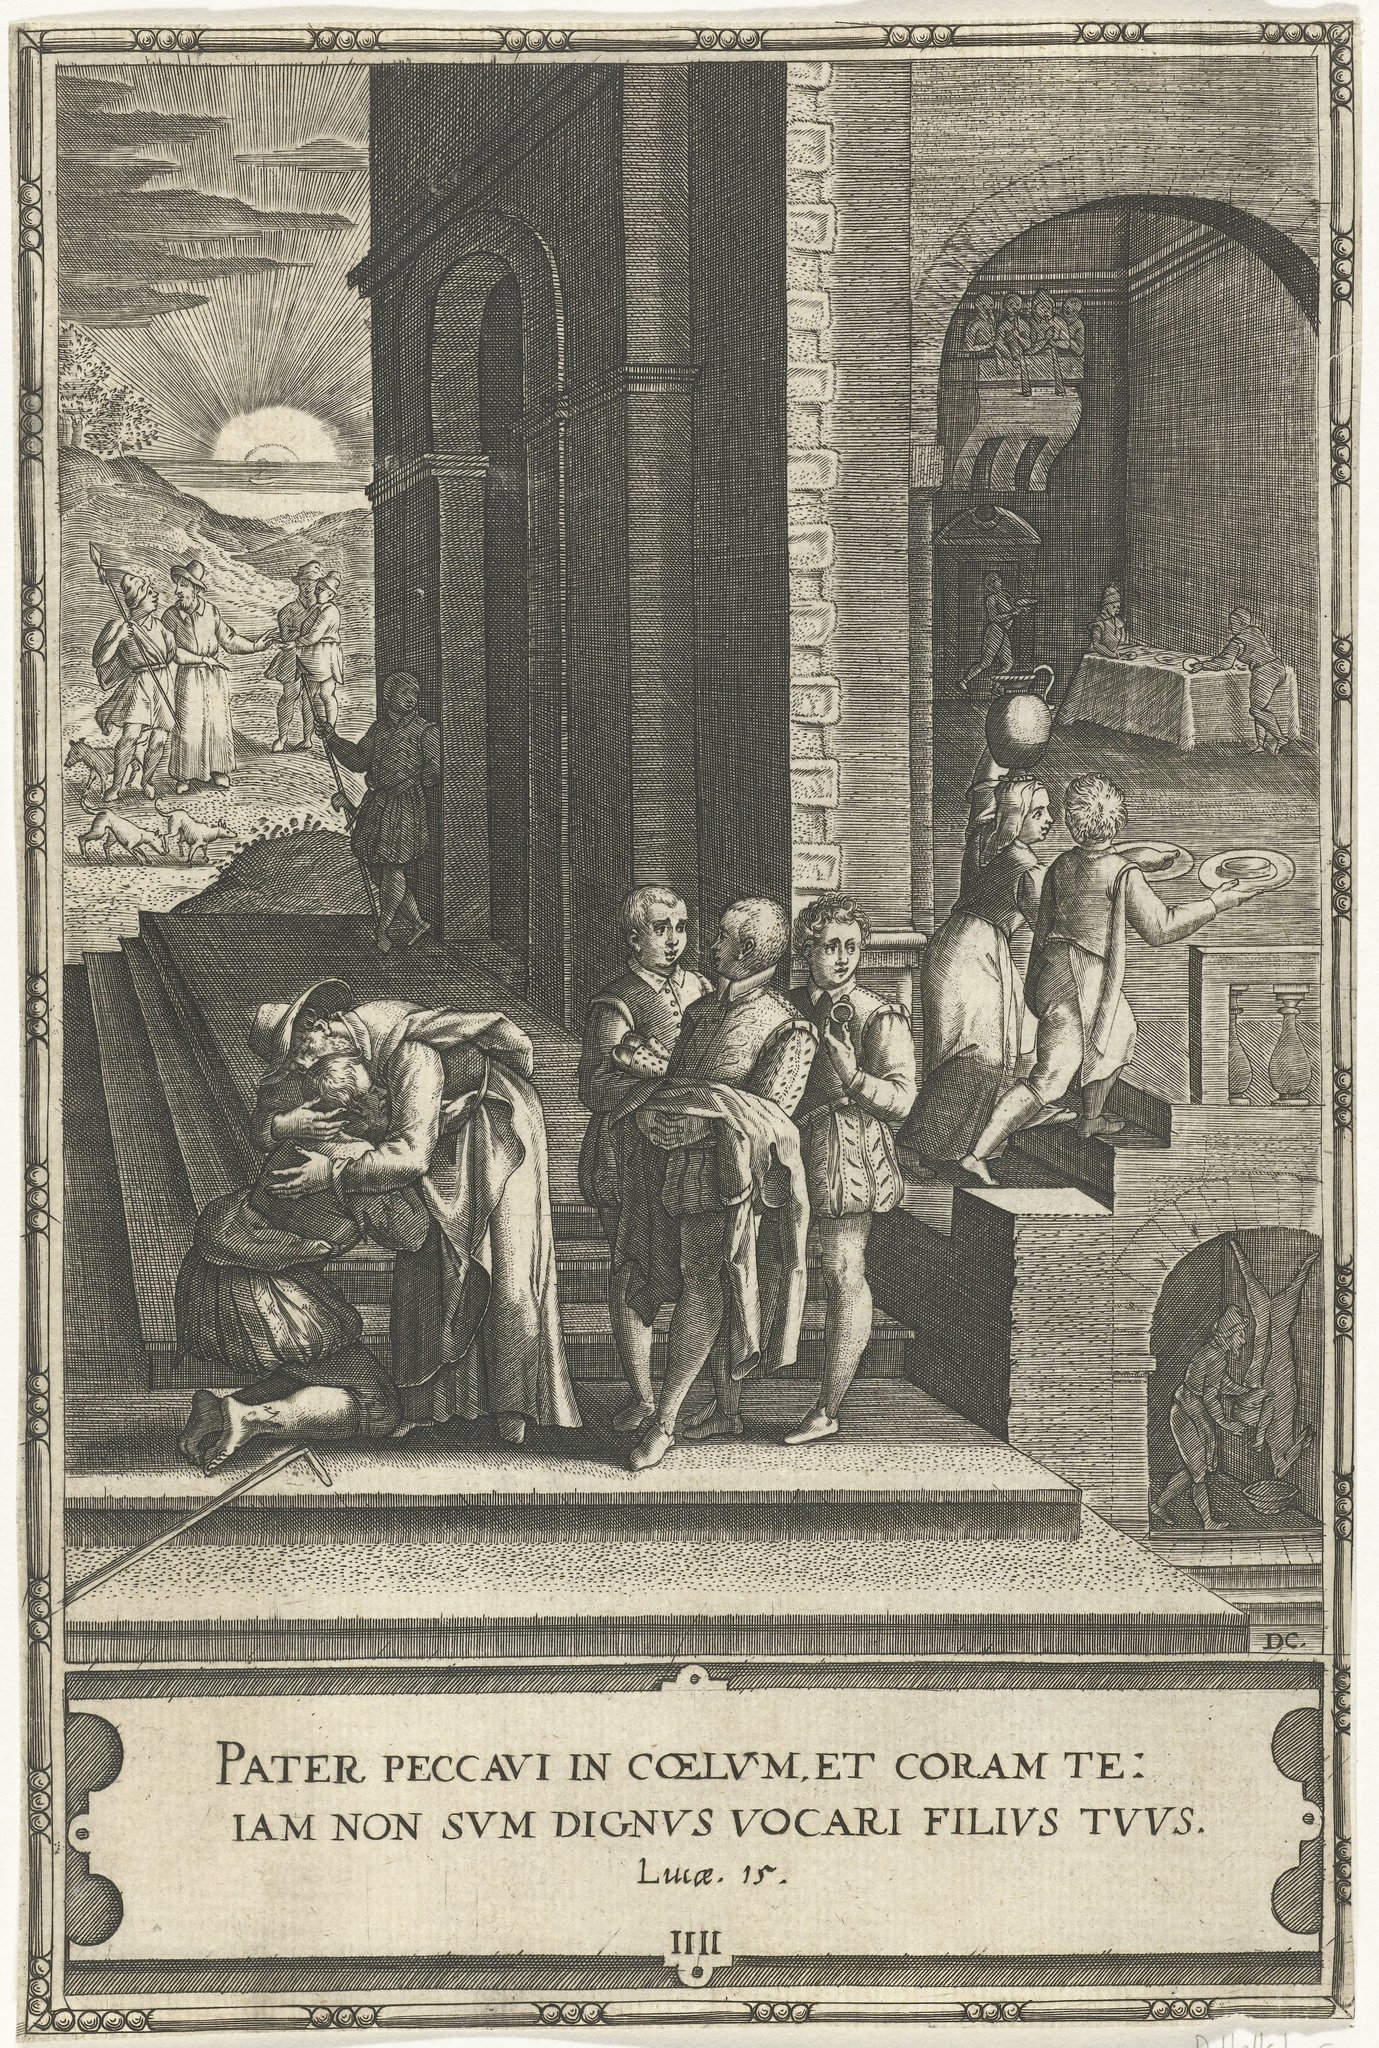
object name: print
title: Gelijkenis van de Verloren Zoon: de verloren zoon komt terug naar huis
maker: dominicus custos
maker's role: print maker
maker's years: 1560-1615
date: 1579-1615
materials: paper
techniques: engraving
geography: augsburg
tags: preparations, e.g. the prodigal son is given new robes; slaughtering of the fatted calf; the elder son objects, the prodigal son returns home, where his father awaits him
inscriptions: collector's mark: Lugt 2228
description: De verloren zoon komt terug naar zijn ouderlijk huis en wordt met open armen ontvangen. Hij knielt voor zijn vader en vraagt om vergeving terwijl die hem kust en omhelst. De andere broers staan klaar met schoenen, kleding en een ring. In de huiskamer wordt de tafel gedekt voor een feestmaal.